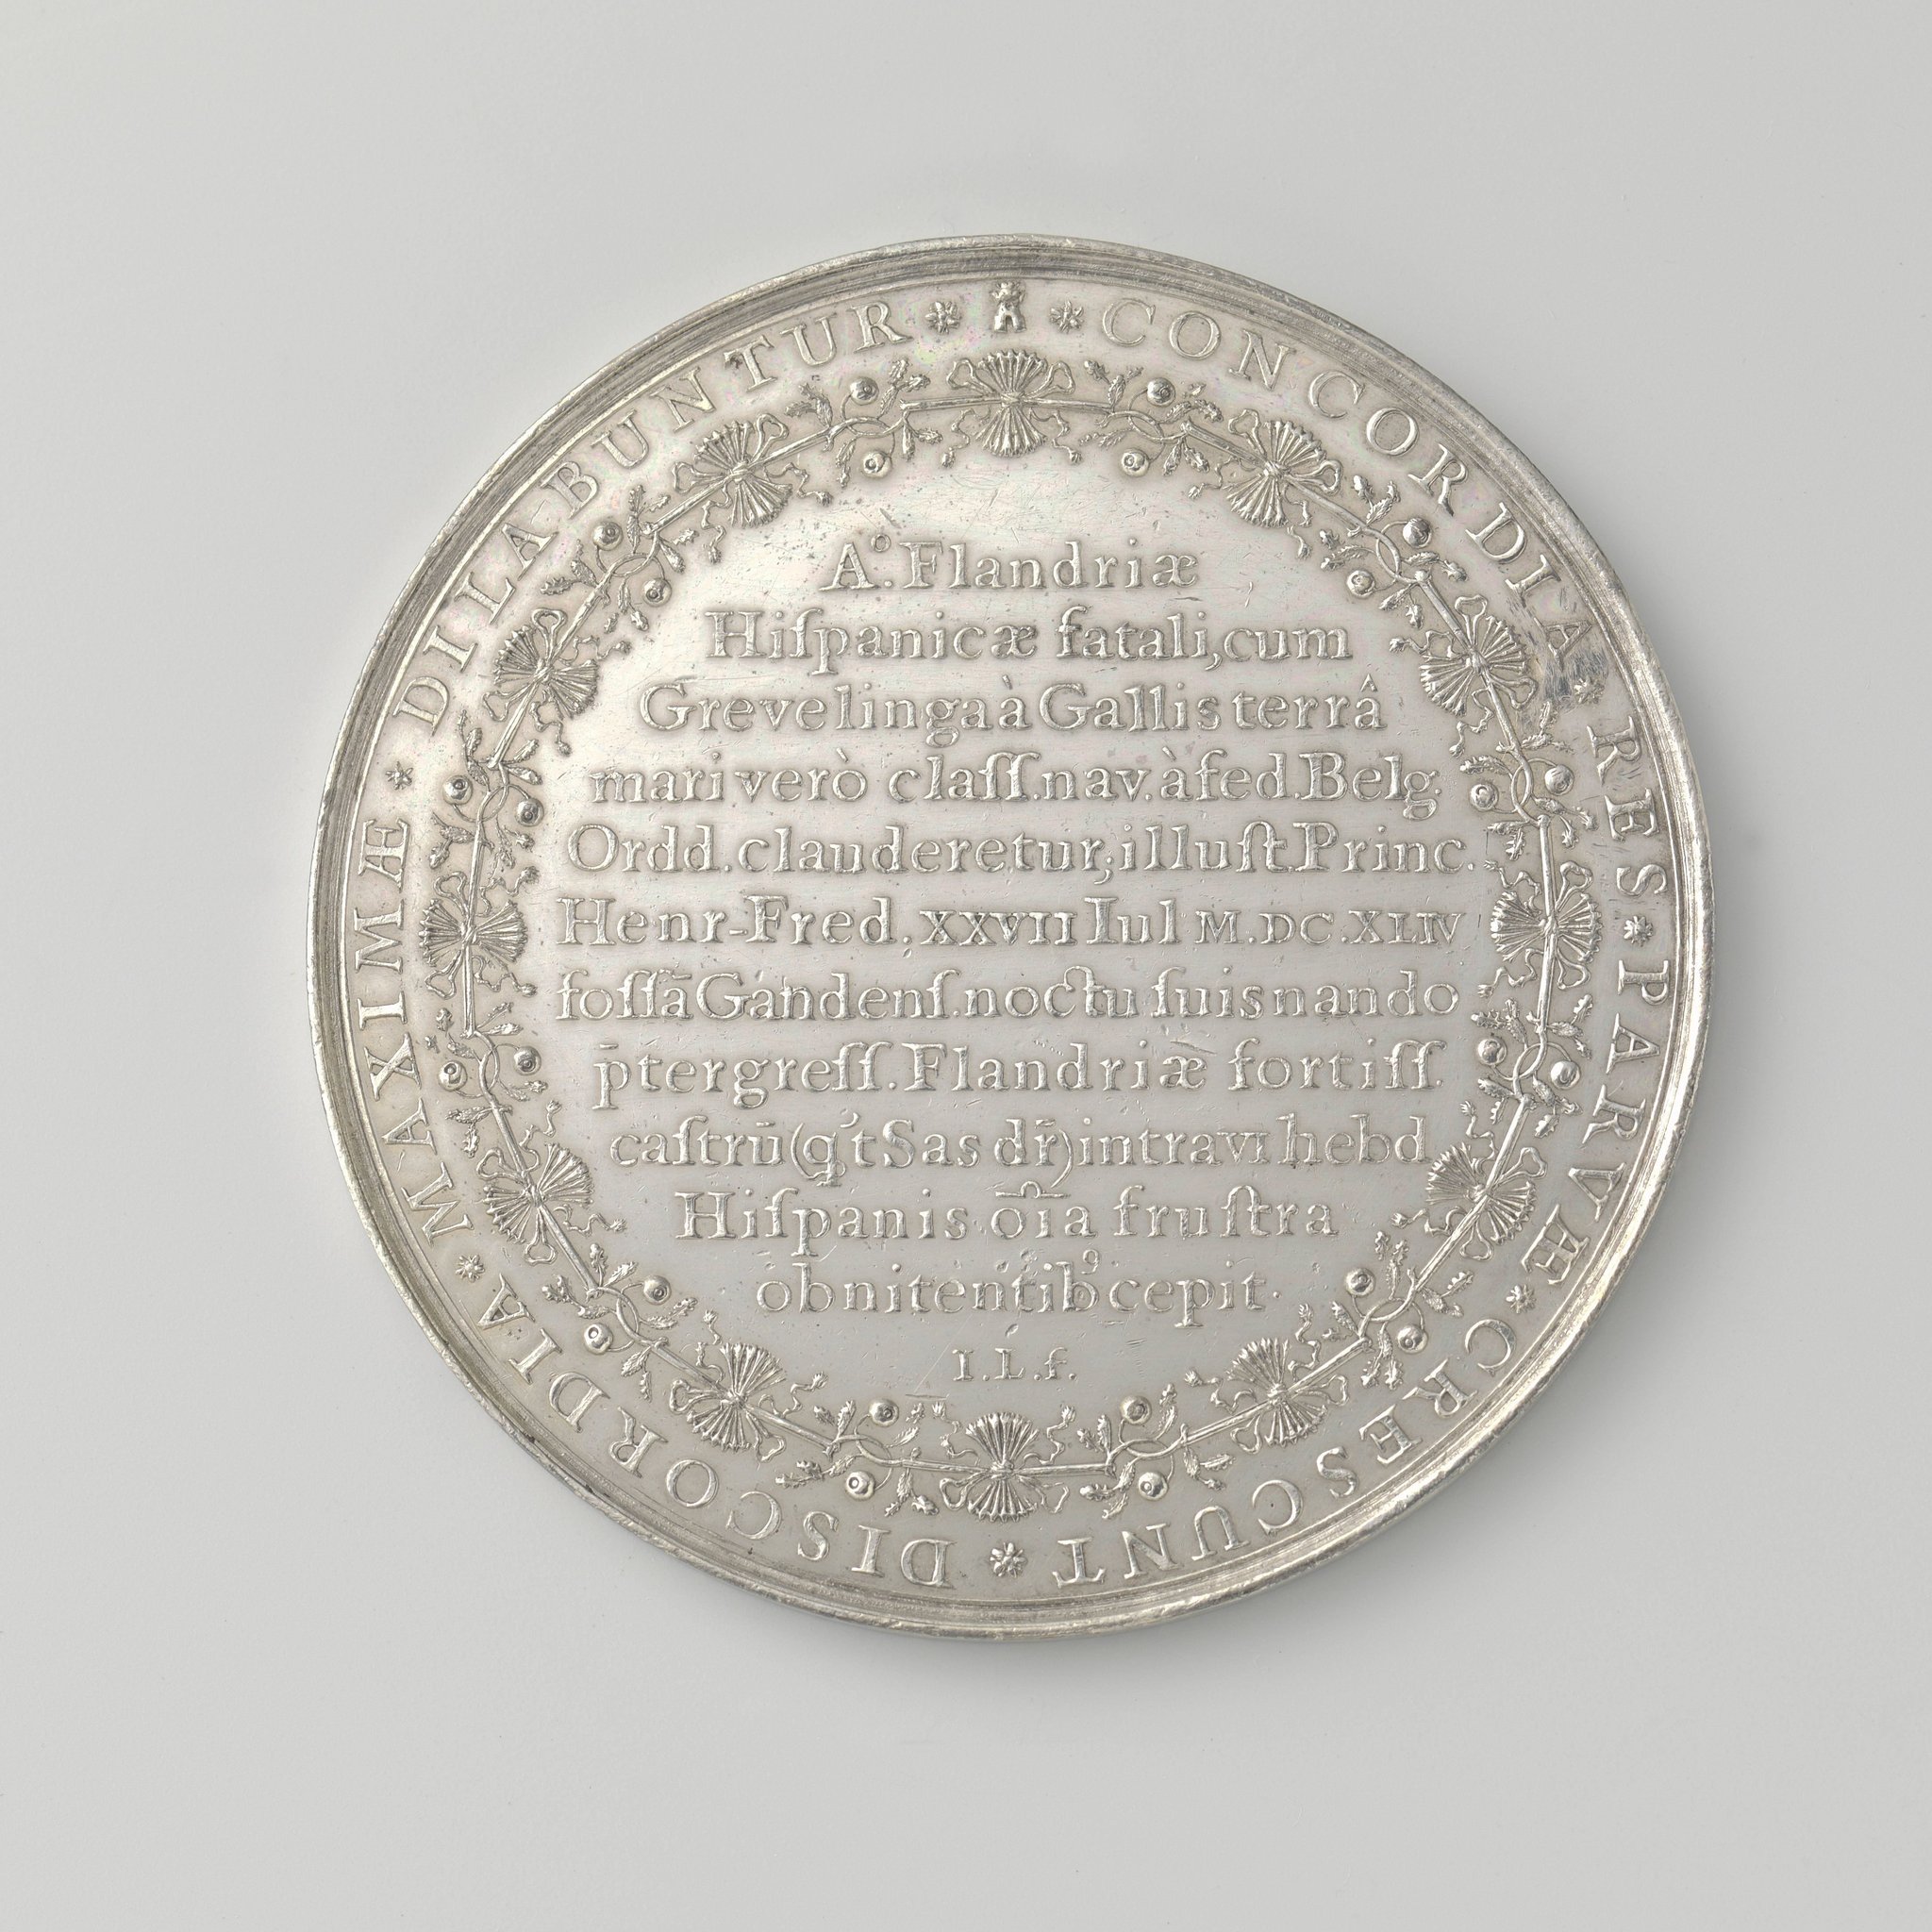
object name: triomfpenning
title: Inname van Sas van Gent door Frederik Hendrik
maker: johannes looff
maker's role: die cutter, draughtsman, print maker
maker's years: -1651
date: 1644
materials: silver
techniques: striking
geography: middelburg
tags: frederick henry (prince of orange), zeeland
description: Zilveren penning. Voorzijde: plattegrond van de veroverde vesting. Keerzijde: opschrift binnen krans van pijlenbundels en oranjetakken binnen omschrift